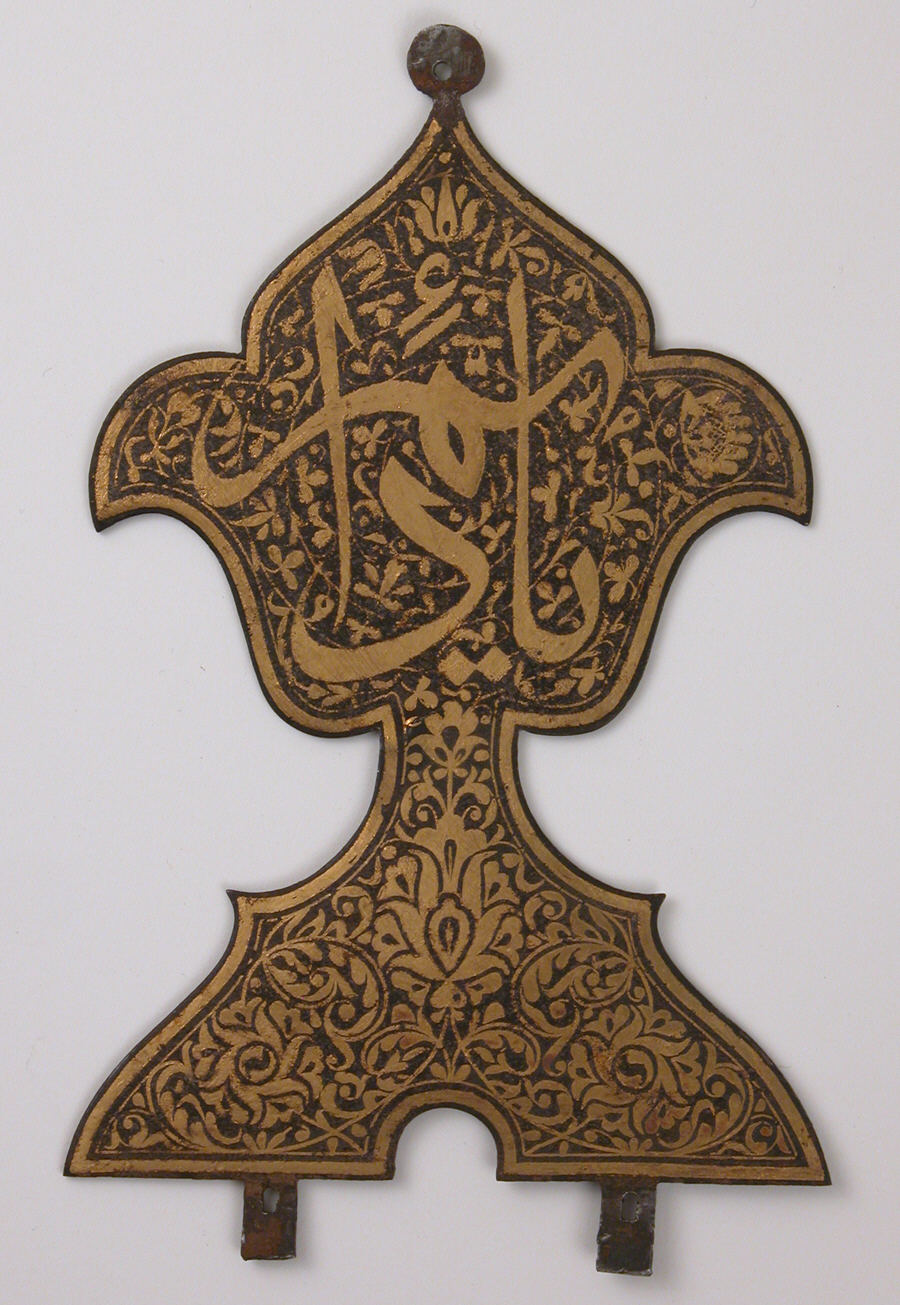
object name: finial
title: Finial with Arabic Inscription"Ya, Da'im" ("Oh, Everlasting!")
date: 1601-1700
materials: foil, gold, silver, steel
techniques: inlay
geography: iran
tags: arabic,calligraphy